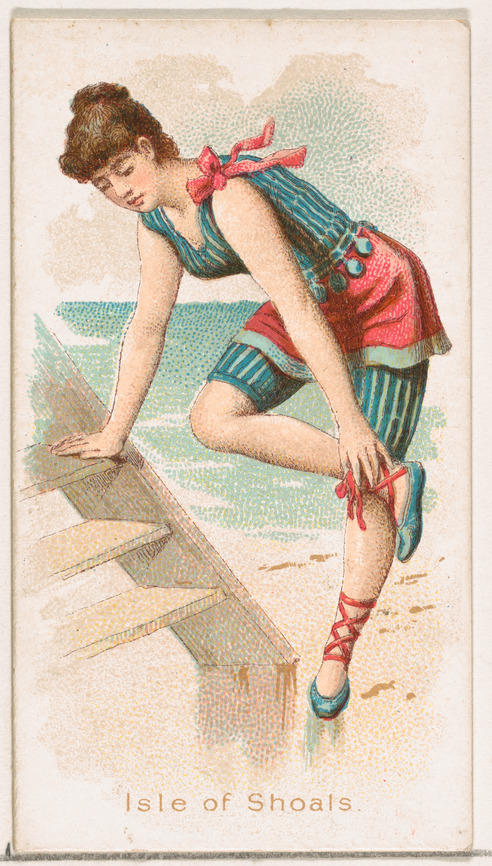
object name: print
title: Isle of Shoals, from the Fancy Bathers series (N187) issued by Wm. S. Kimball & Co.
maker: william s. kimball & company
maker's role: publisher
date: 1889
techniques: color lithograph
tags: women